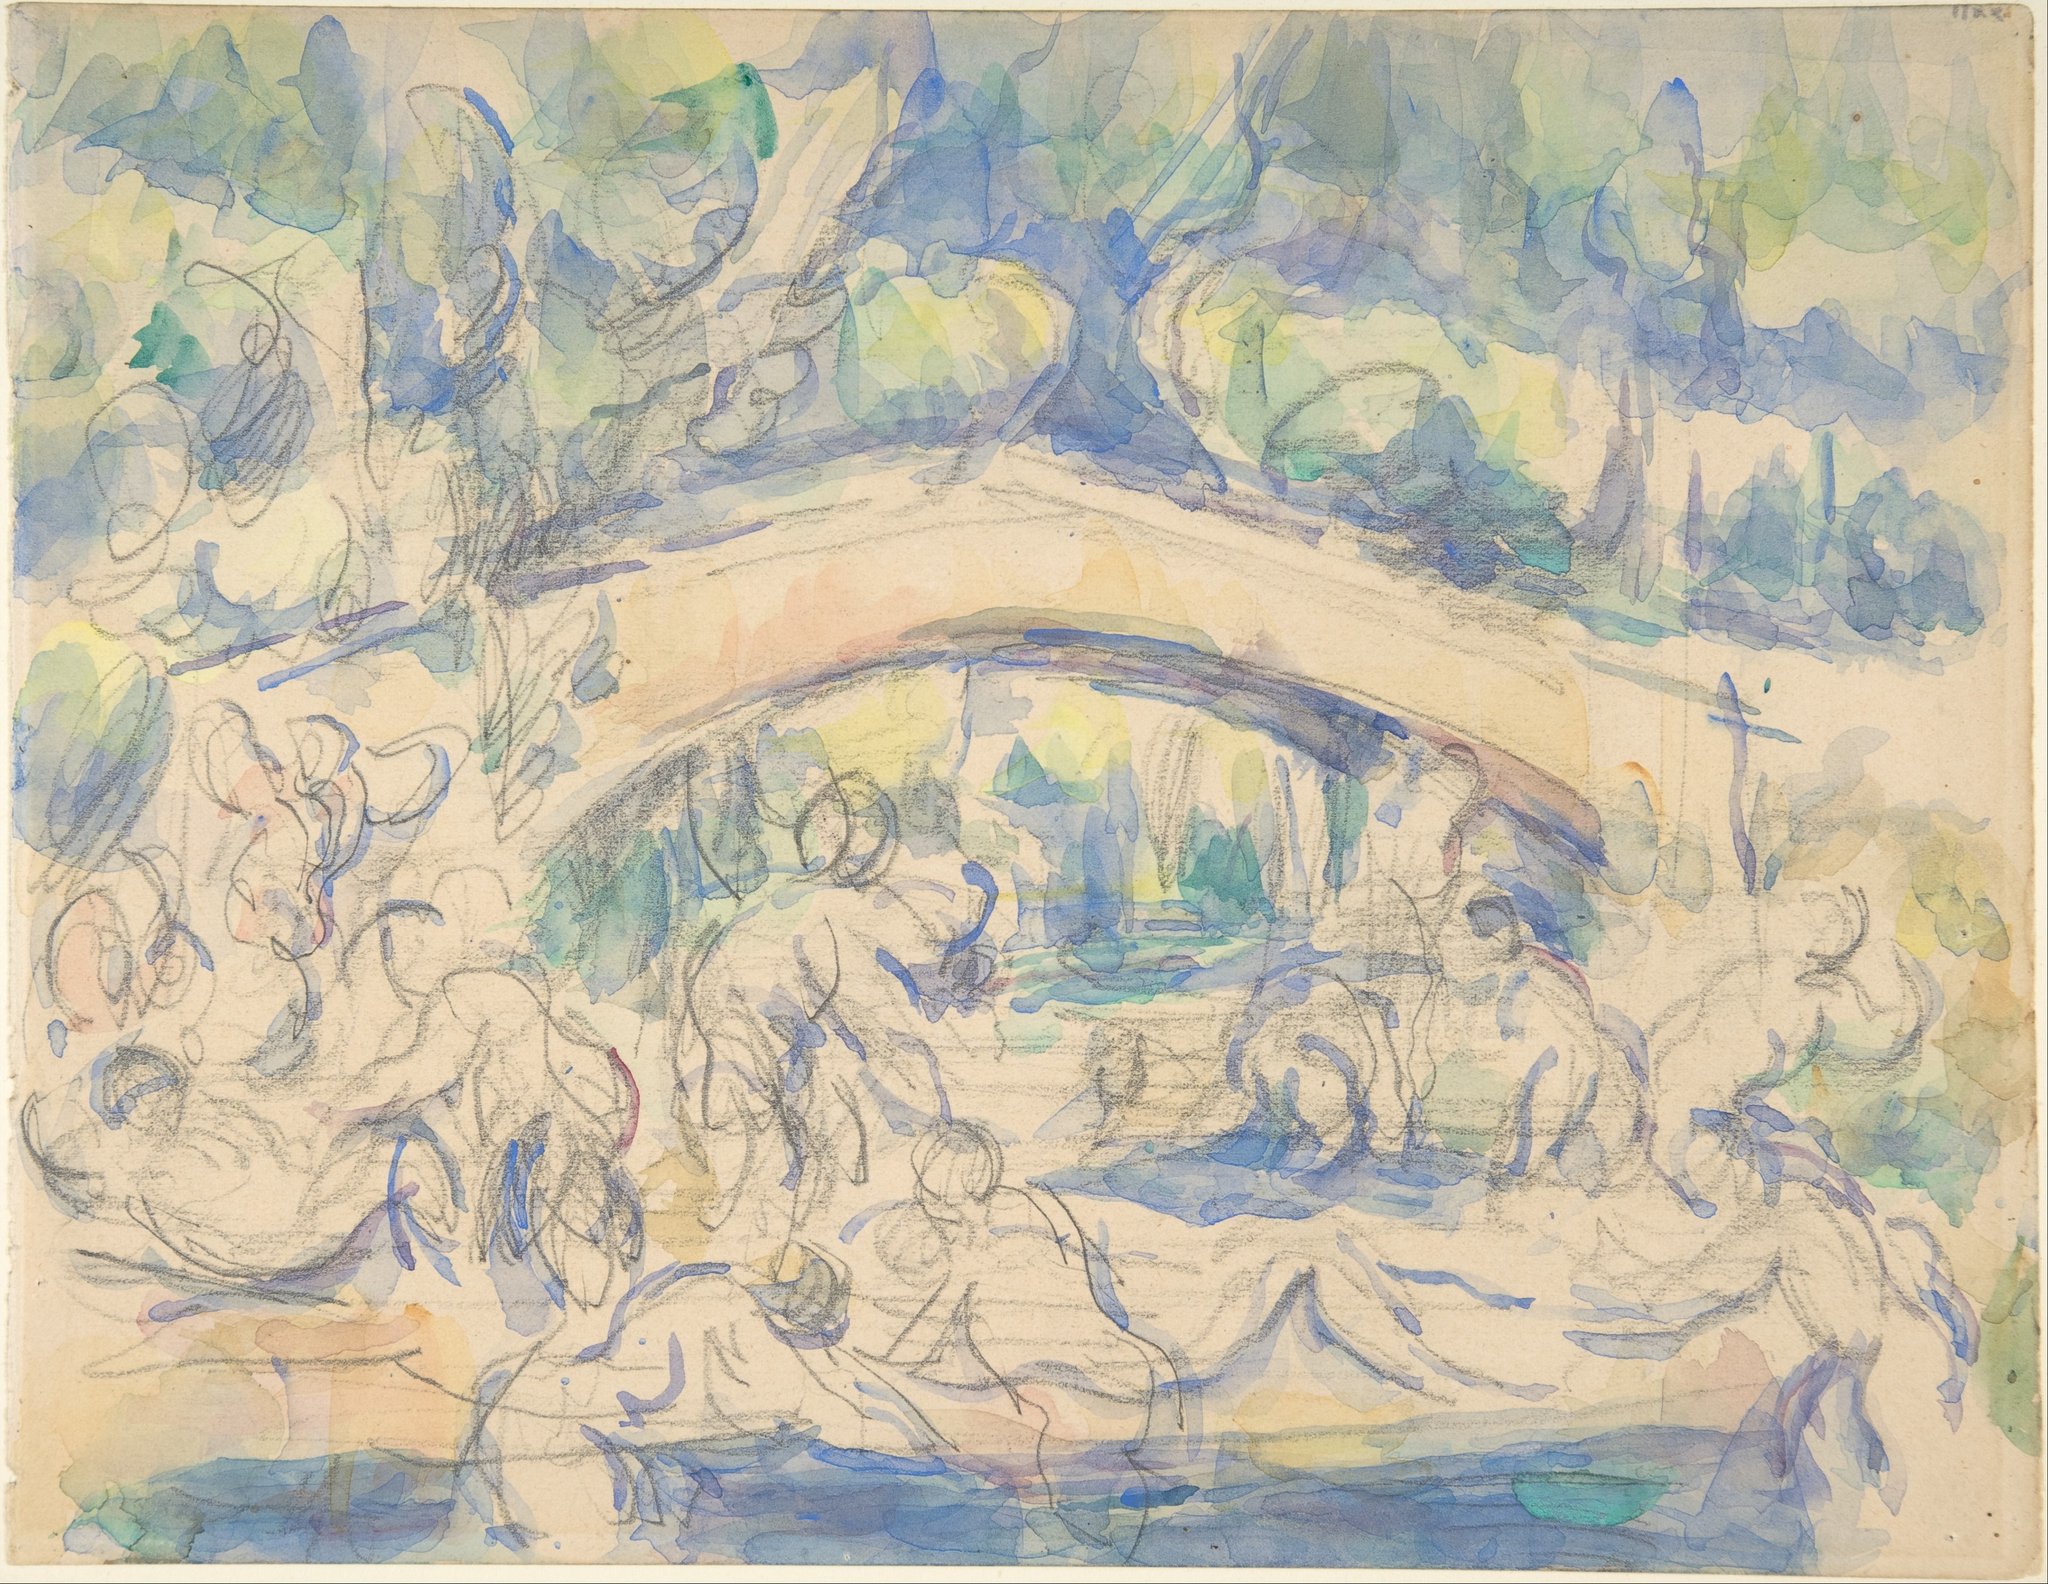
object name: drawing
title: Bathers Under a Bridge (recto); Study after Houdon's Ecorché (verso)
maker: paul cézanne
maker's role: artist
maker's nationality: french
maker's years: 1839-1906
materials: graphite, watercolor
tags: bridges,bathing